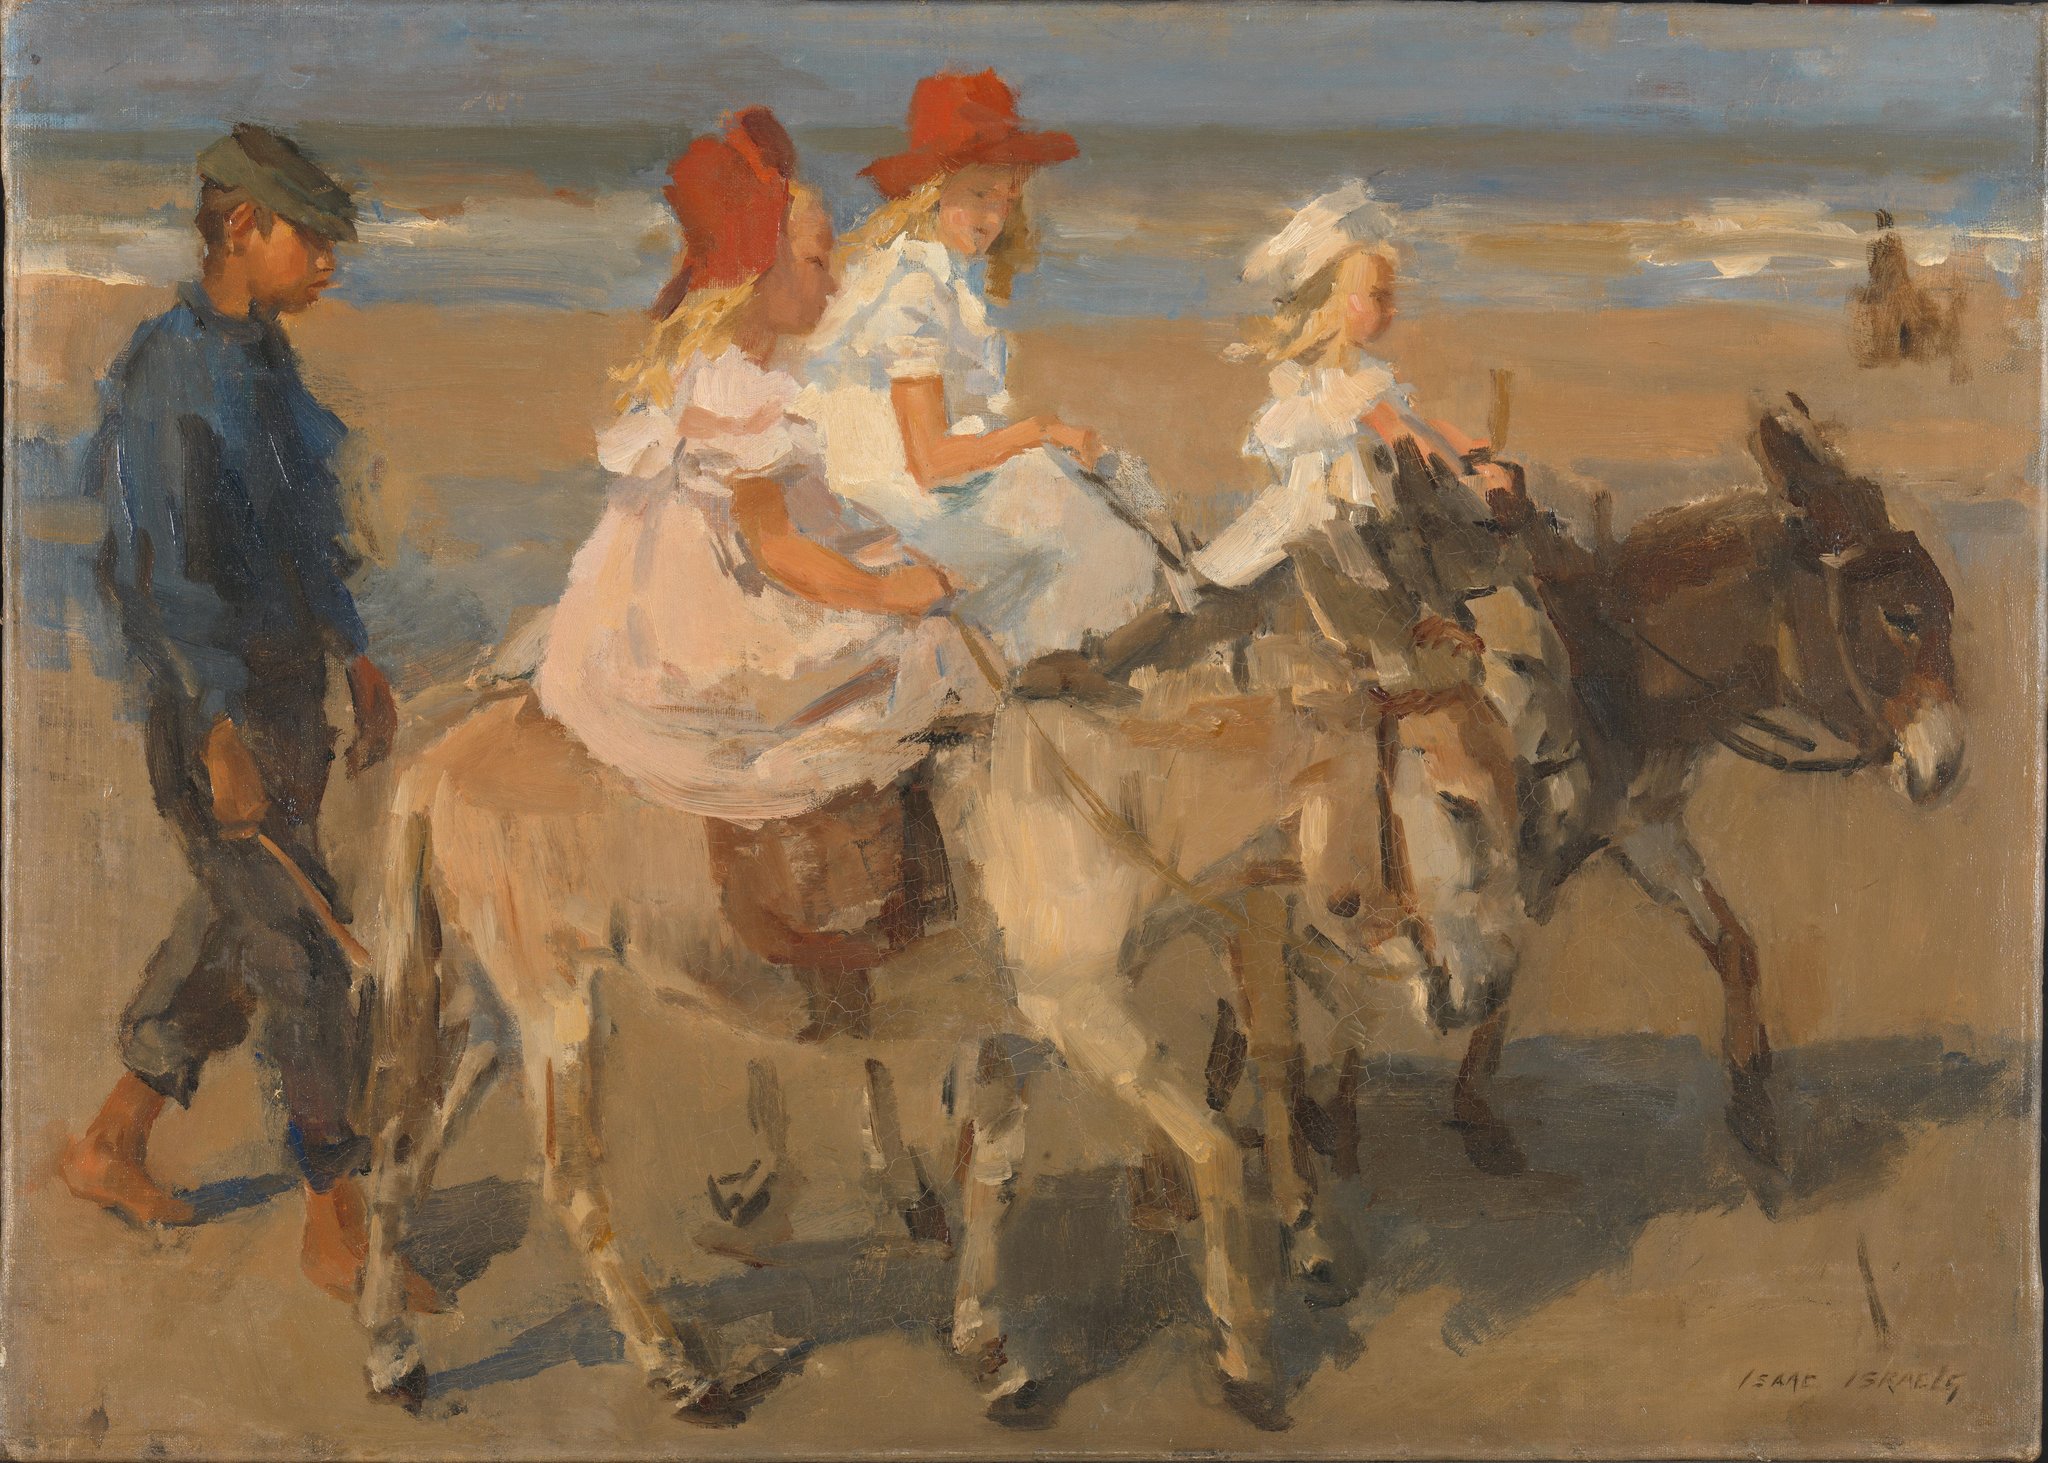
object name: painting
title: Donkey Rides on the Beach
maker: isaac israels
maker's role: draughtsman, painter, print maker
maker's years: 1865-1934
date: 1890-1901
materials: canvas, oil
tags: child between toddler and youth (of undetermined sex), donkey-riding (on the beach)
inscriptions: signature: ‘Isaac Israels’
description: In contrast to Hague School painters, Isaac Israels depicted the carefree, touristic aspect of the seaside resort of Scheveningen. He often used models for these scenes – in this case, his acquaintances Suze Pont, Agatha Pauw and her little sister. Israels worked rapidly: ‘Never work too much, no more than two hours at a stretch, do not fuss too long, otherwise you will lose your freshness.’